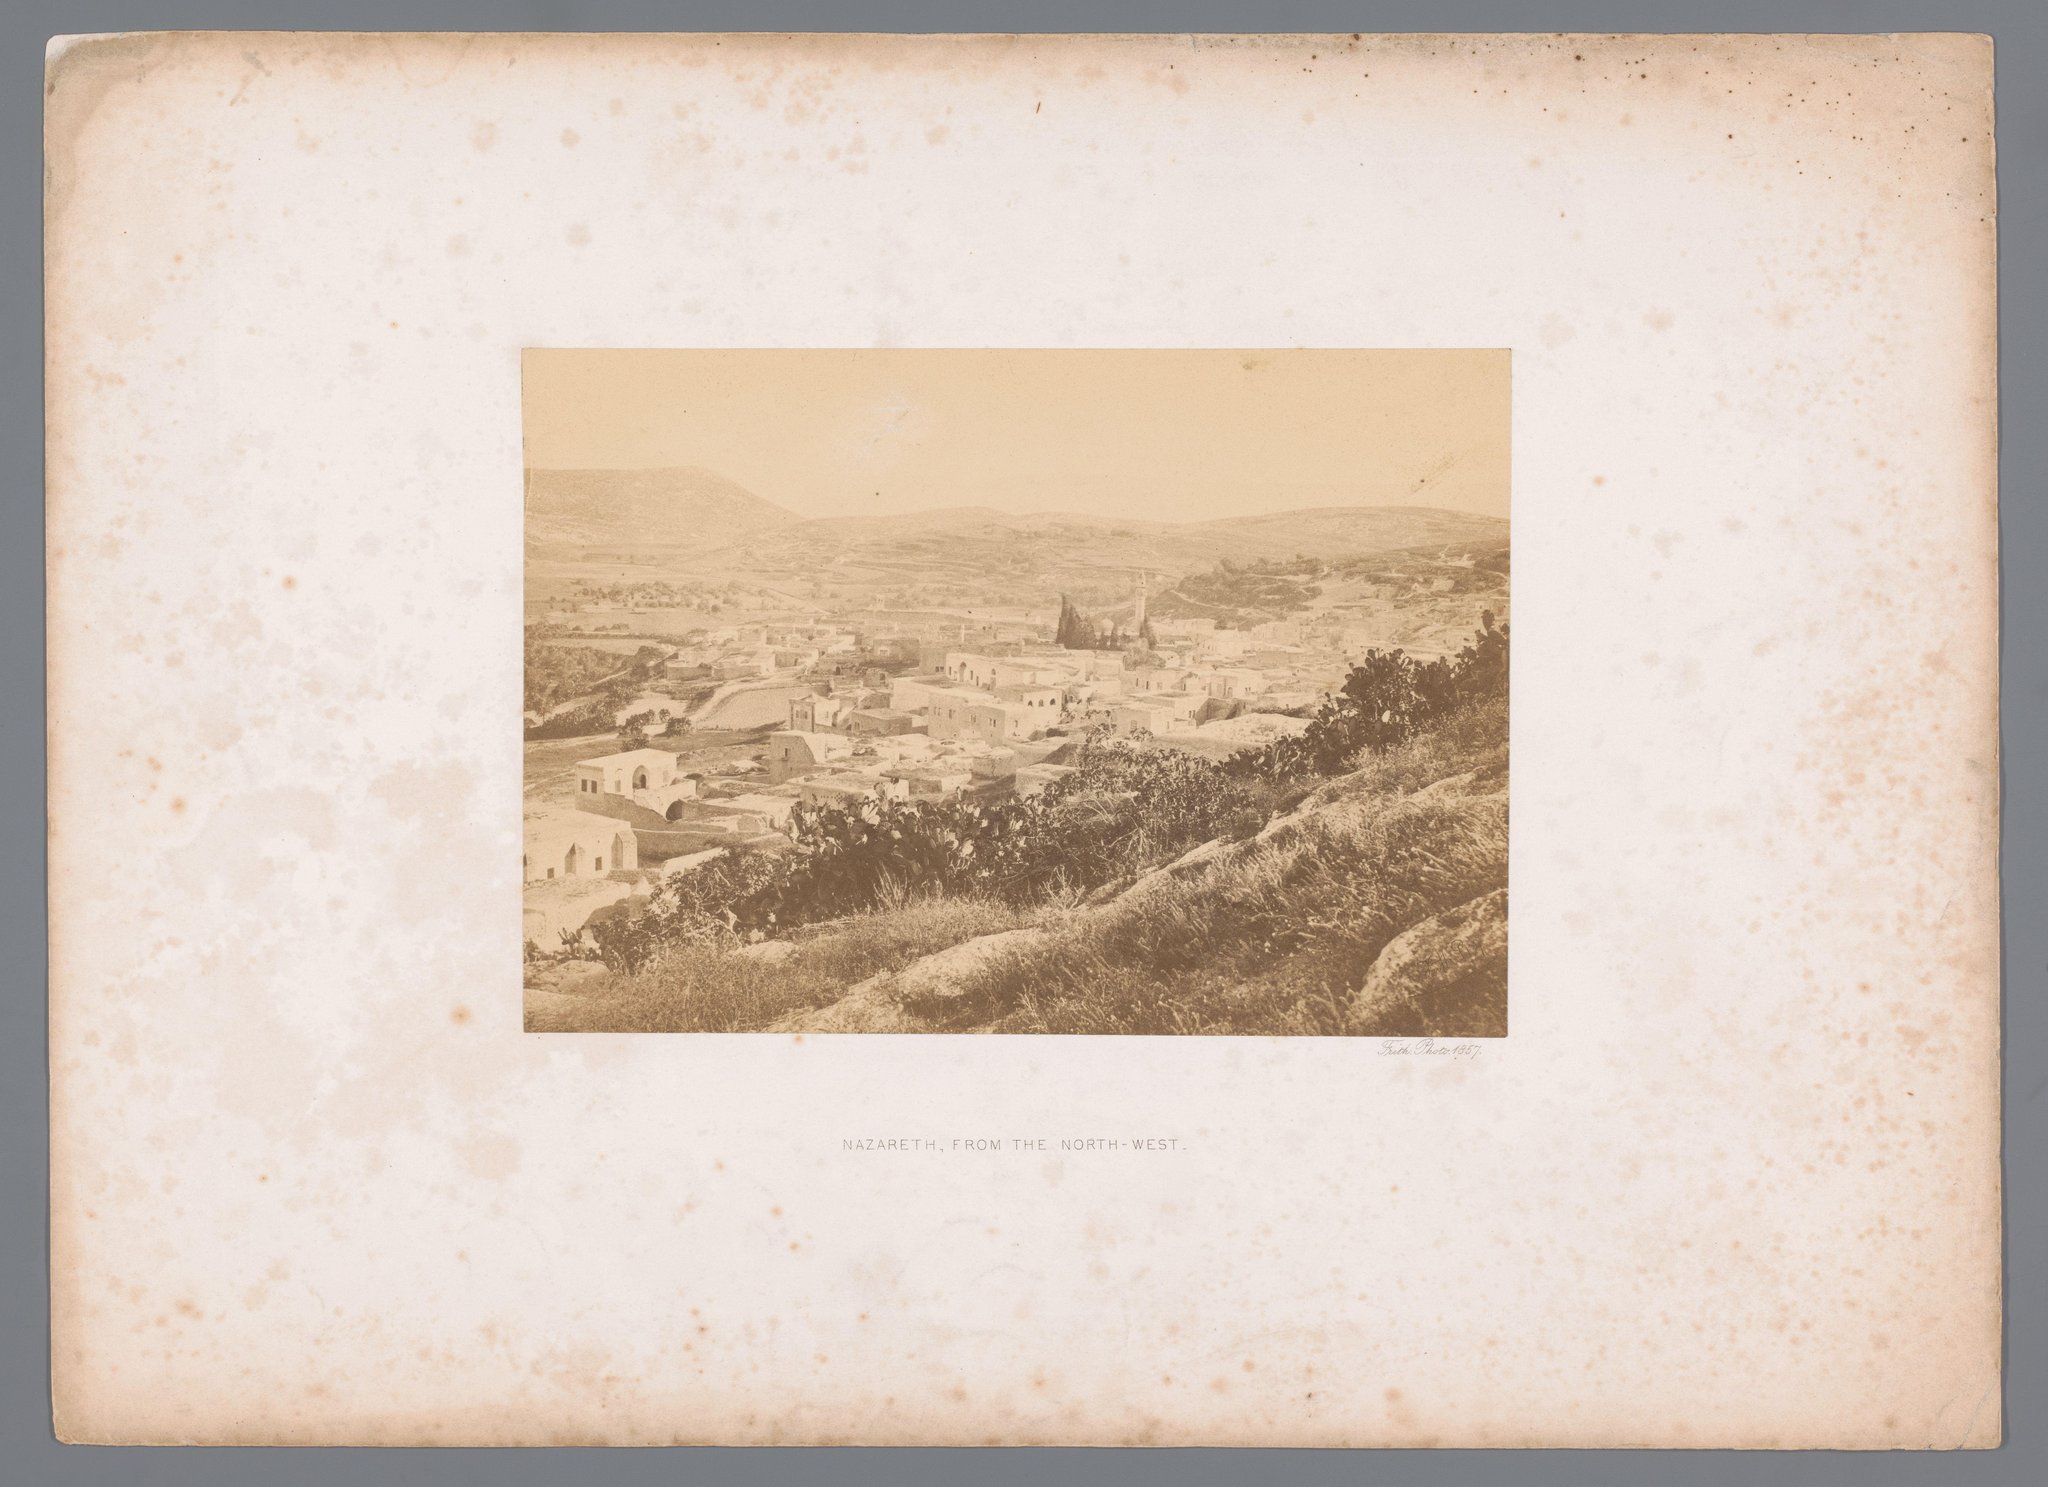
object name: page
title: Nazareth, from the north-west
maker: francis frith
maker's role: publisher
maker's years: 1822-1898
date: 1857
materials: paper, photographic support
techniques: albumen print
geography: nazareth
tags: publisher, francis frith, city-view, and landscape with man-made constructions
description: Deze foto maakt deel uit van een omslag met 7 bladen met albuminedrukken.